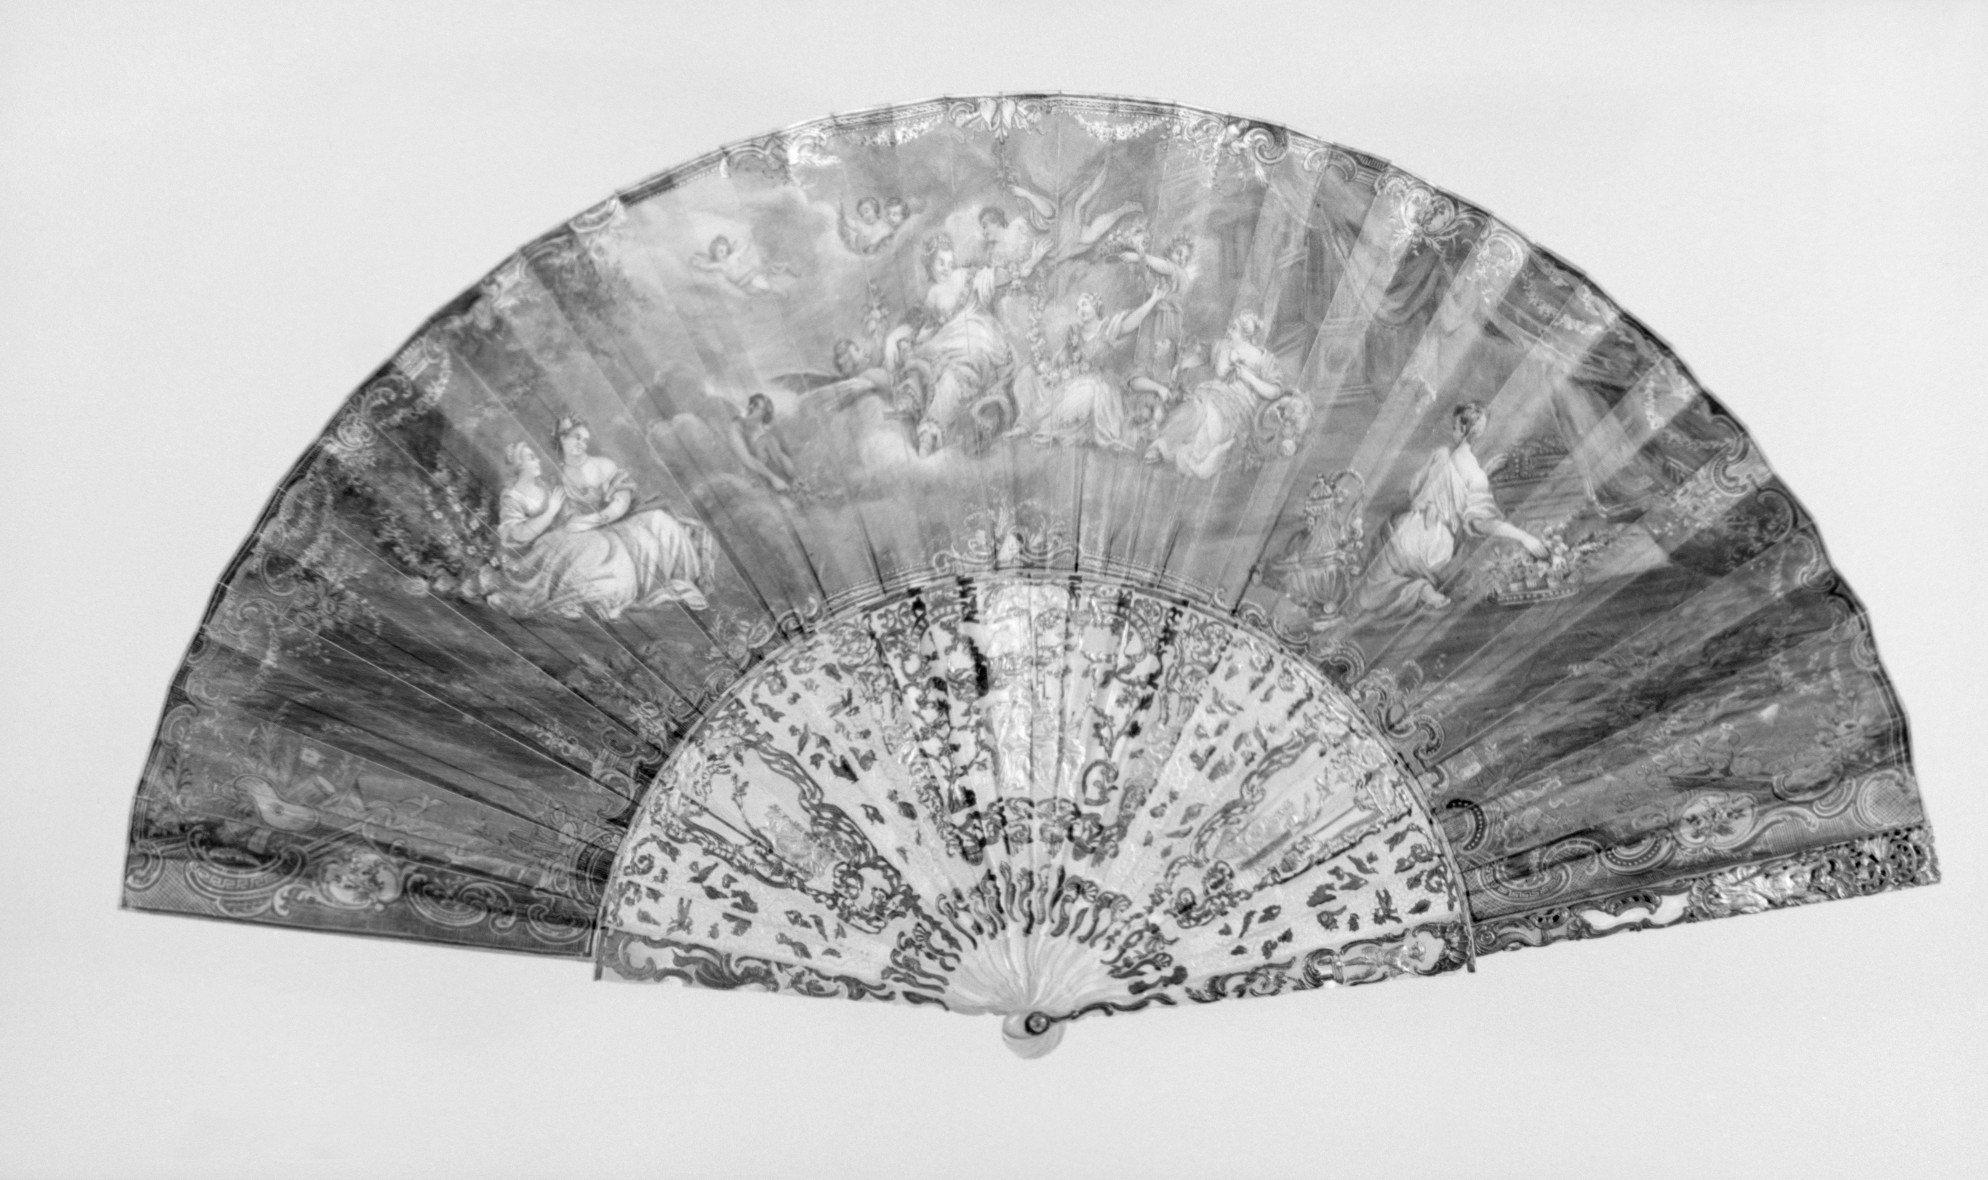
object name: fan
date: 1701-1800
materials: mother of pearl, paper, parchment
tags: women